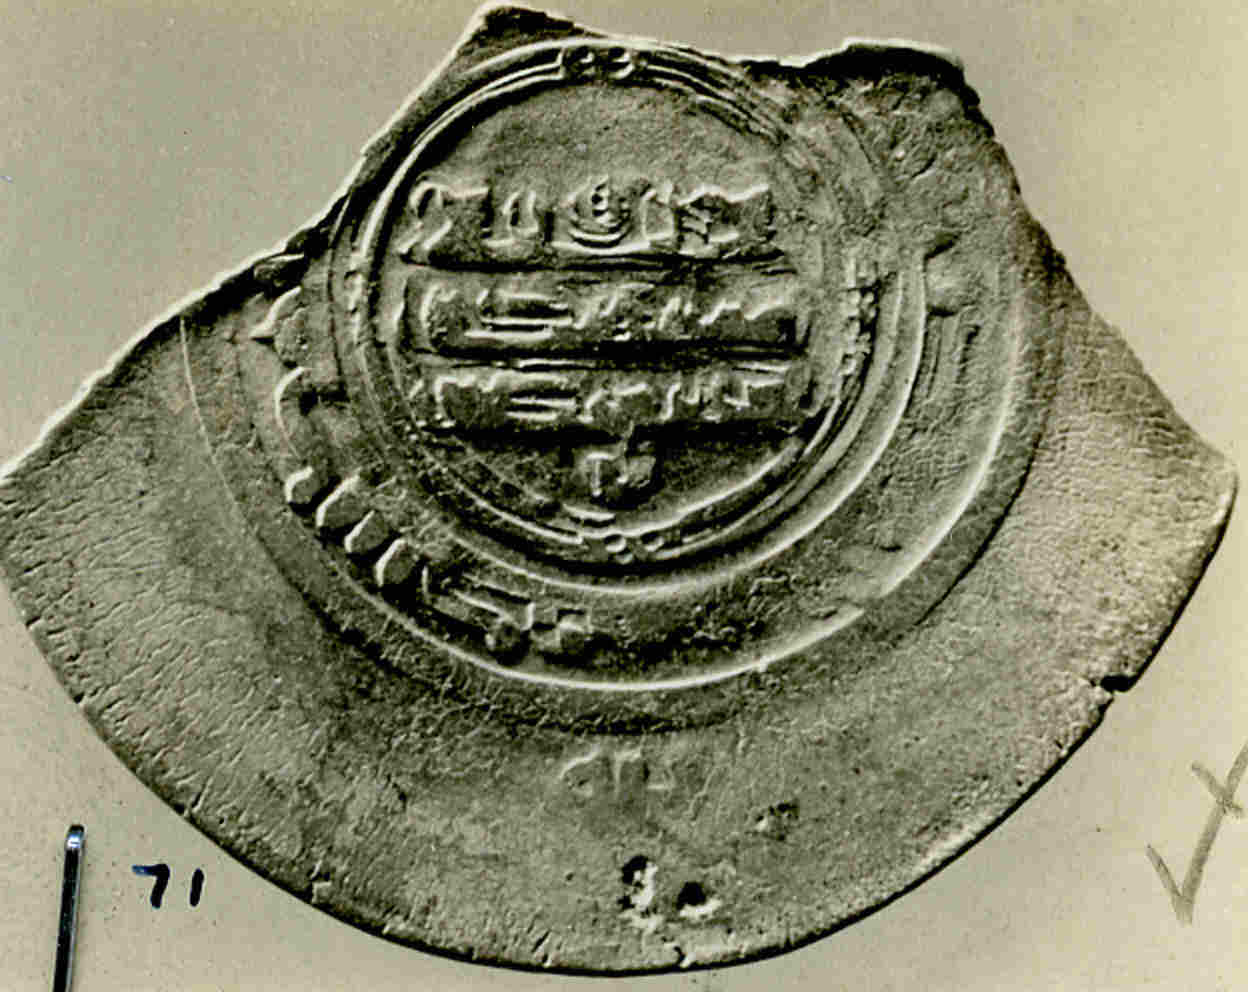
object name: coin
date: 951-1022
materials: silver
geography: madan....